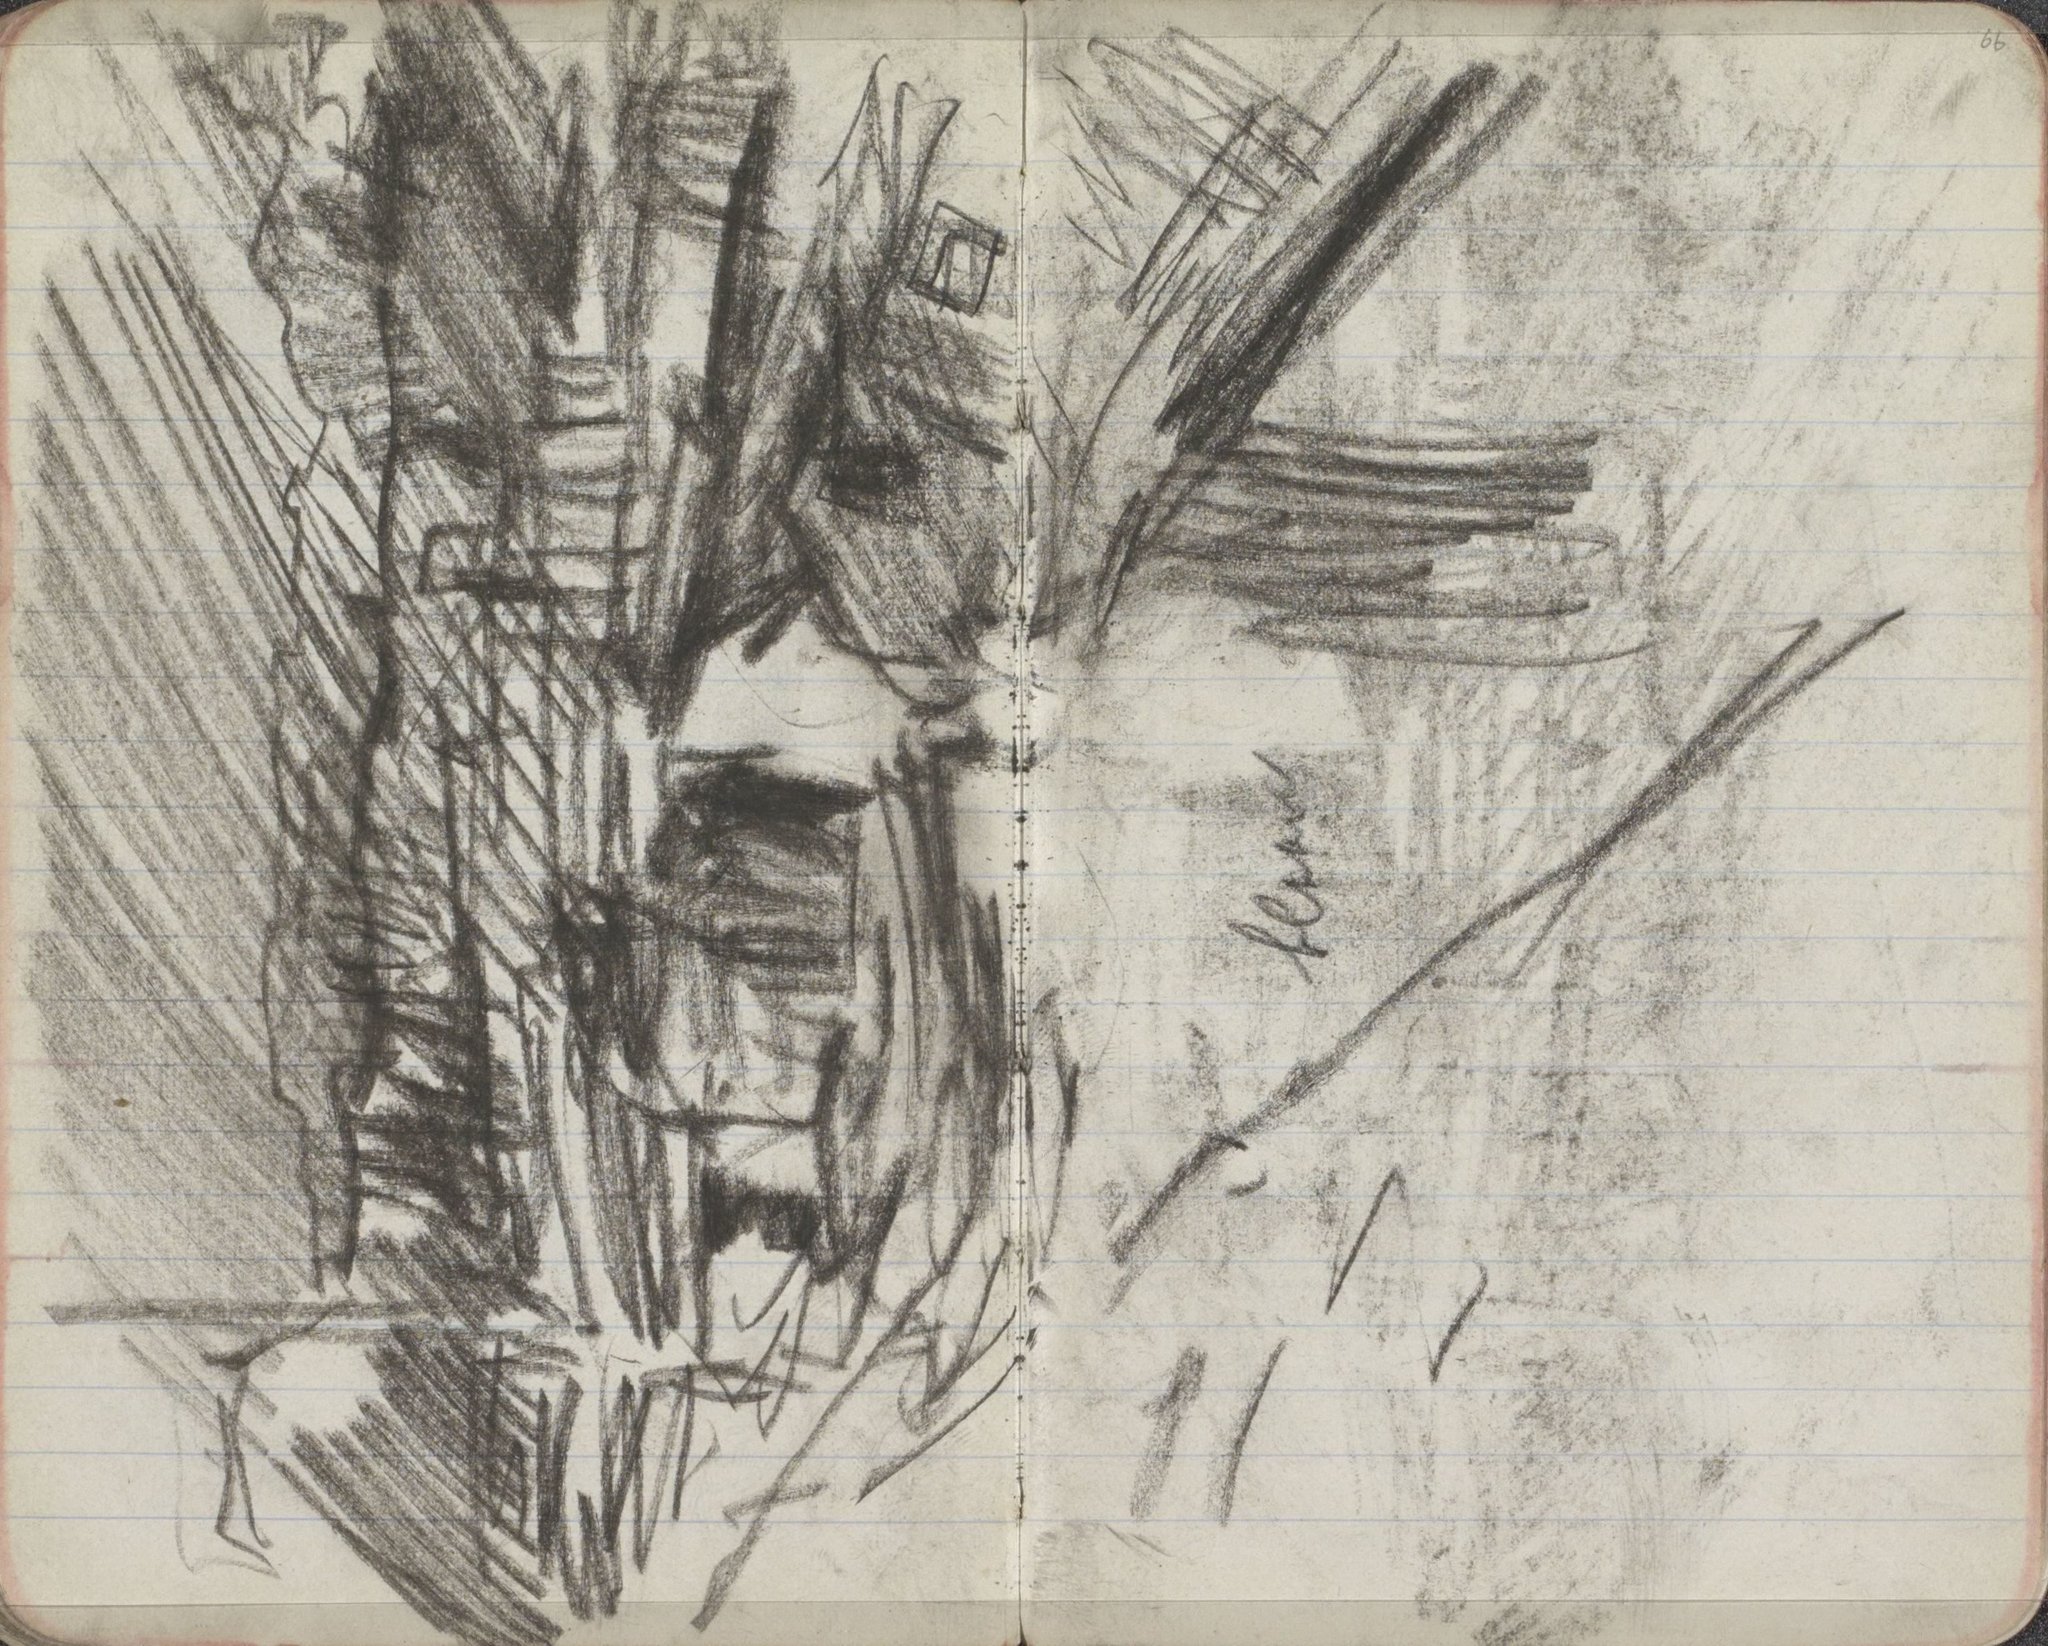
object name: sketchbook leaf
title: Schepen bij Bickerseiland te Amsterdam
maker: george hendrik breitner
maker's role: draughtsman, painter, print maker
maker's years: 1857-1923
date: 1892-1900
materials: chalk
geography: amsterdam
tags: ships (in general), canals, waters (in city), civic architecture; edifices; dwellings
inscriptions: kleurnotitie, handgeschreven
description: Pagina 65 en pagina 66 uit een schetsboek met 38 bladen.